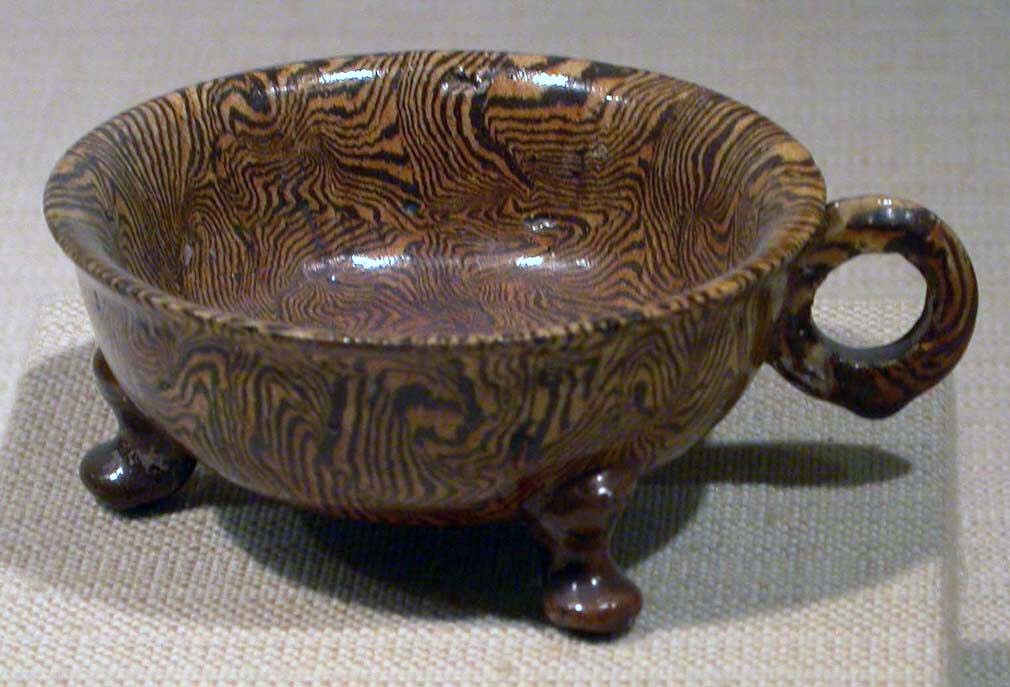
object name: cup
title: Tripod cup with ring handle (bei)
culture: chinese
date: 701-750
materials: earthenware, glaze